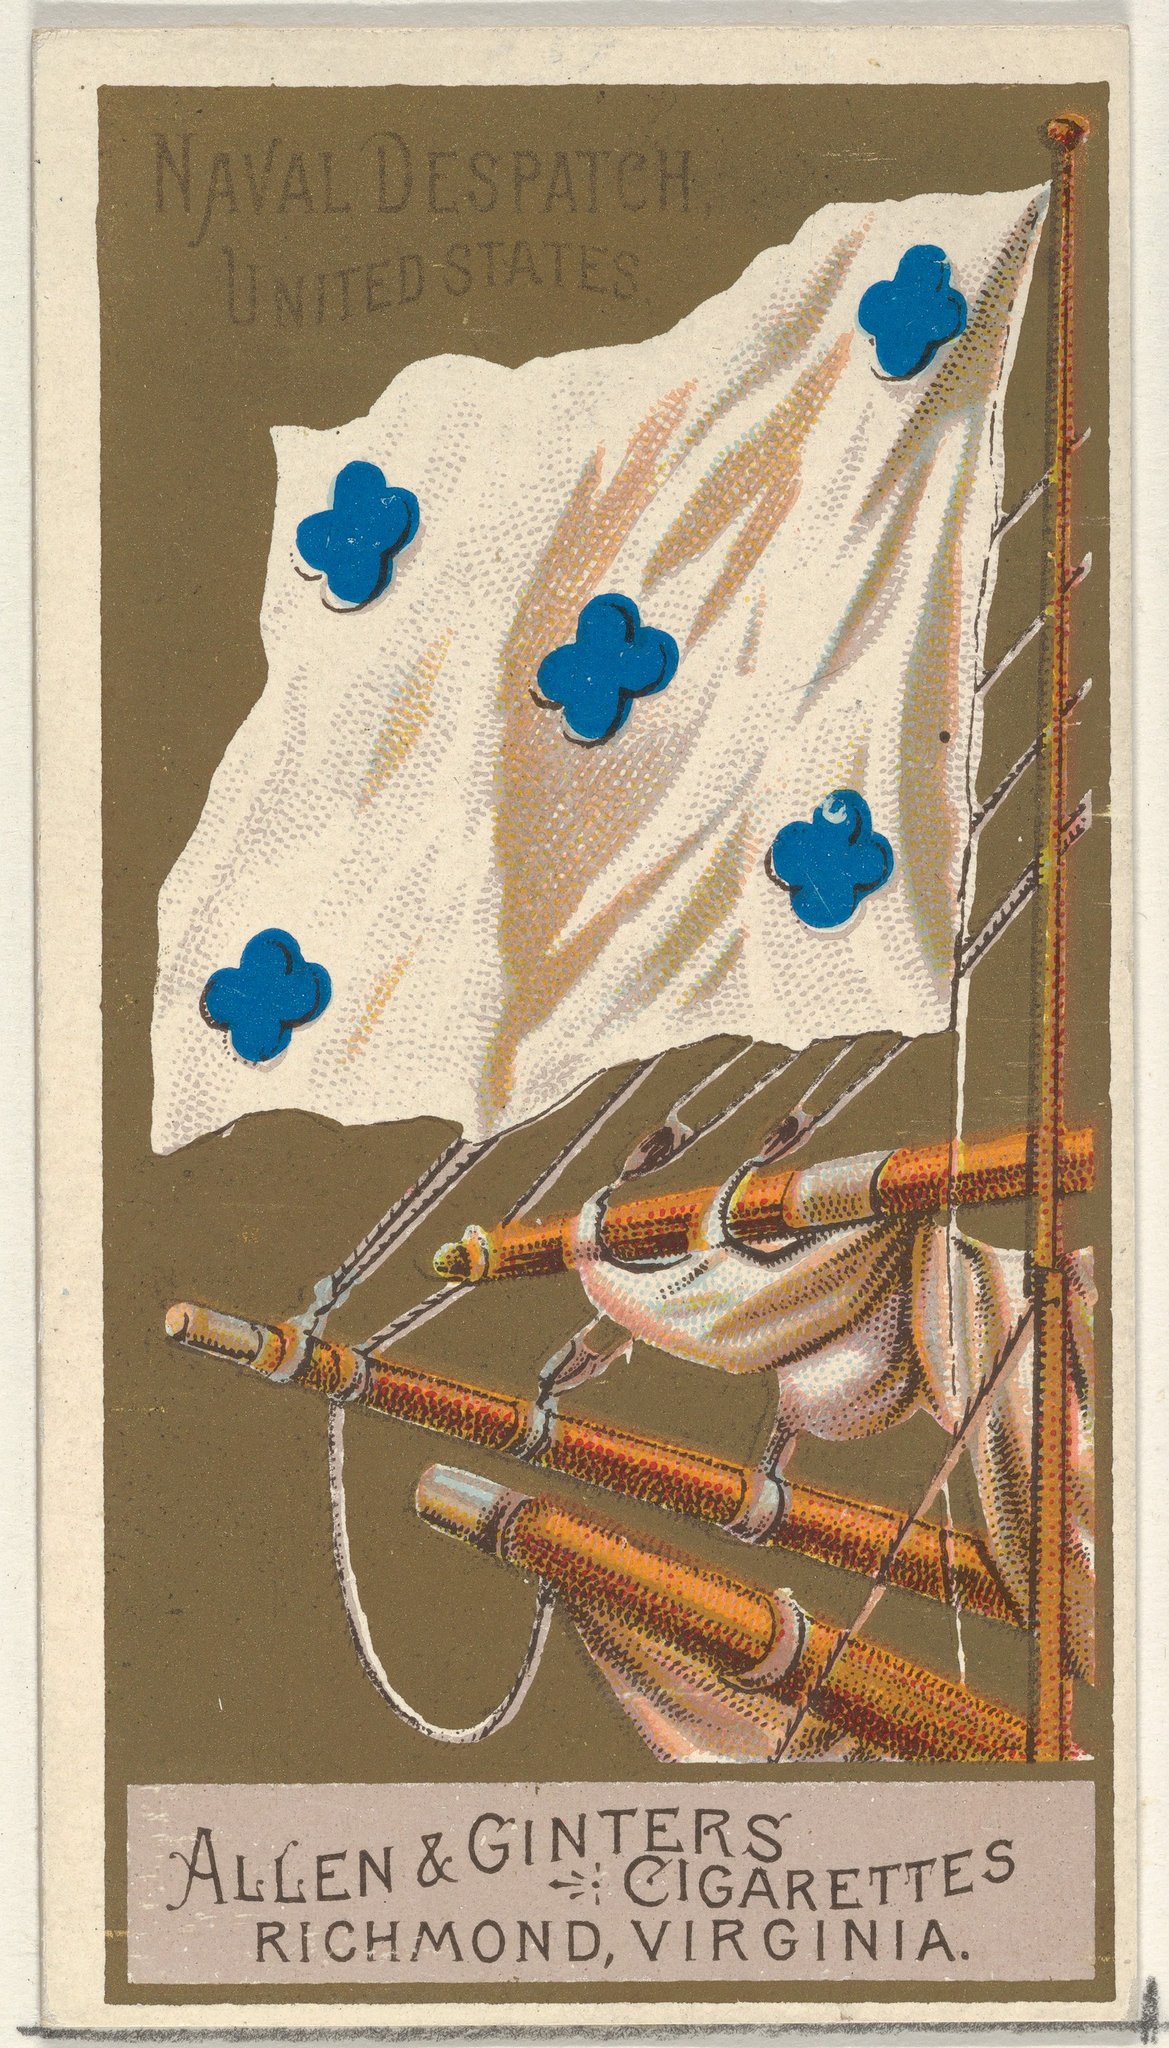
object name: print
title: Naval Dispatch, United States, from the Naval Flags series (N17) for Allen & Ginter Cigarettes Brands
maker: allen & ginter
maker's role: publisher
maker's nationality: american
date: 1888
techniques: color lithograph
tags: flags